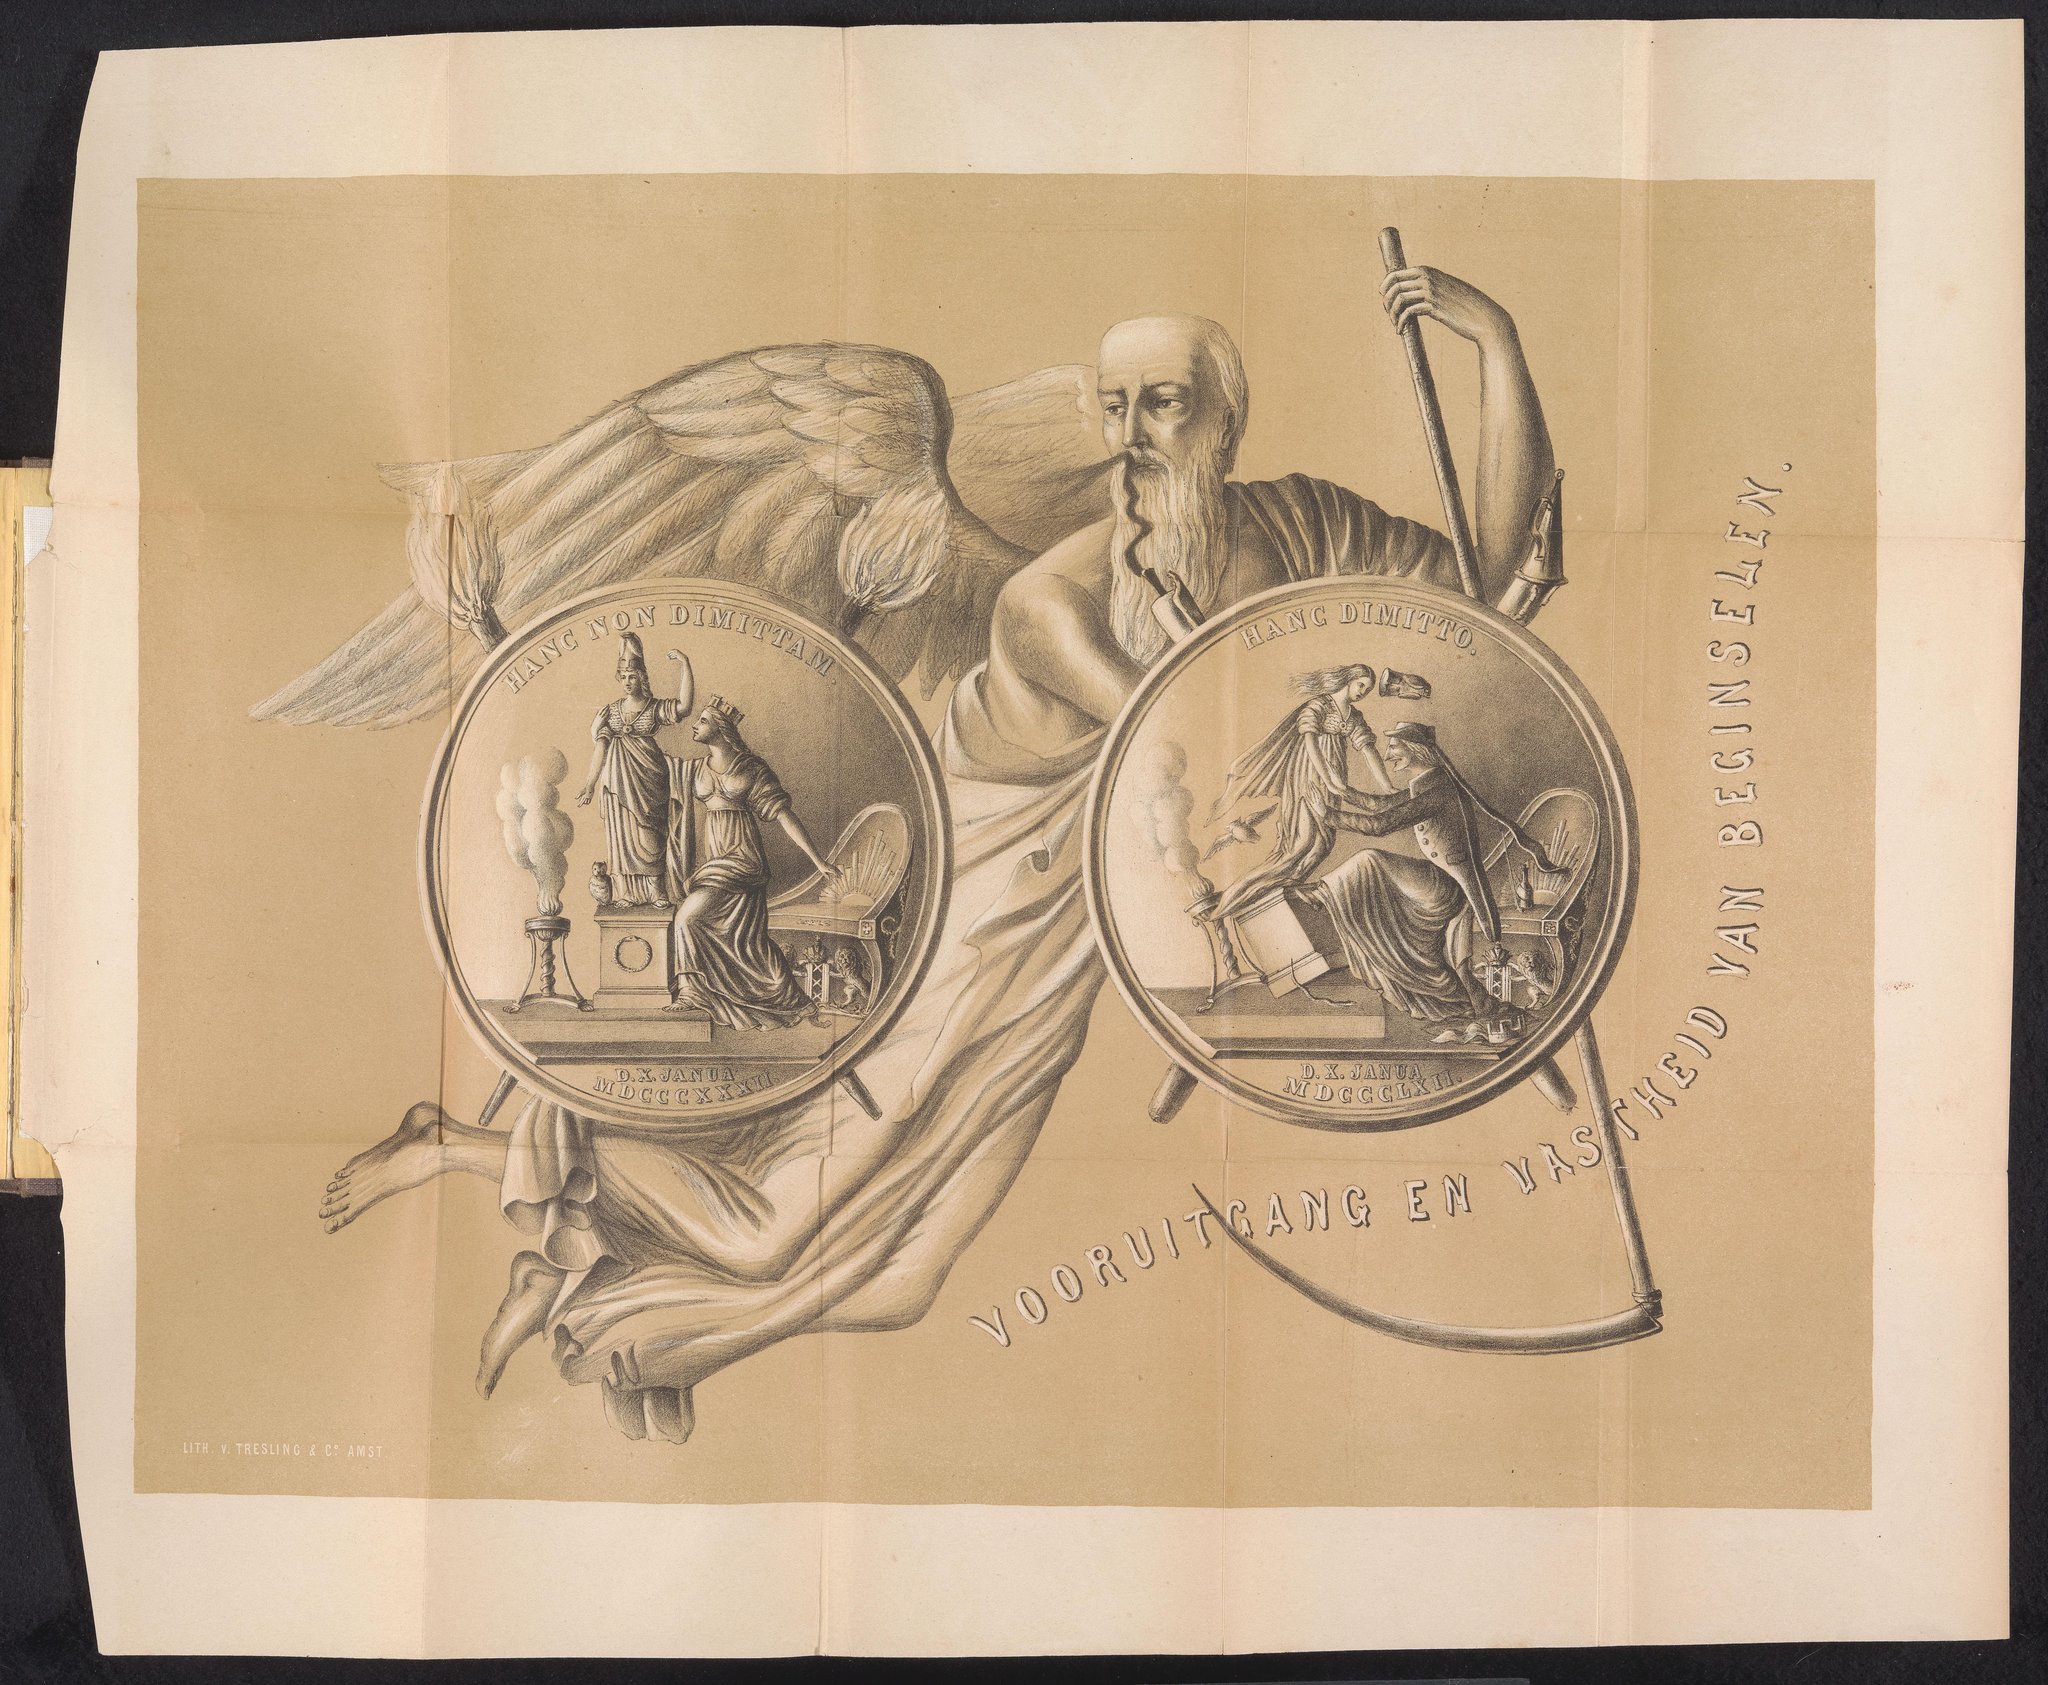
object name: print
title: Vooruitgang en Vastheid van Beginselen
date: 1862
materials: paper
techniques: tone lithography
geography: amsterdam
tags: medal (considered as a piece of sculpture, regardless of its specific function), student life, father time, man with wings and scythe, amsterdam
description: Vader Tijd met twee gedenkpenningen. Naar aanleiding van de voorgestelde verandering van het Athenaeum Illustre in een Gemeentelijke Universiteit. Spotprent in de studentenalmanak van de Universiteit van Amsterdam van het jaar 1862.